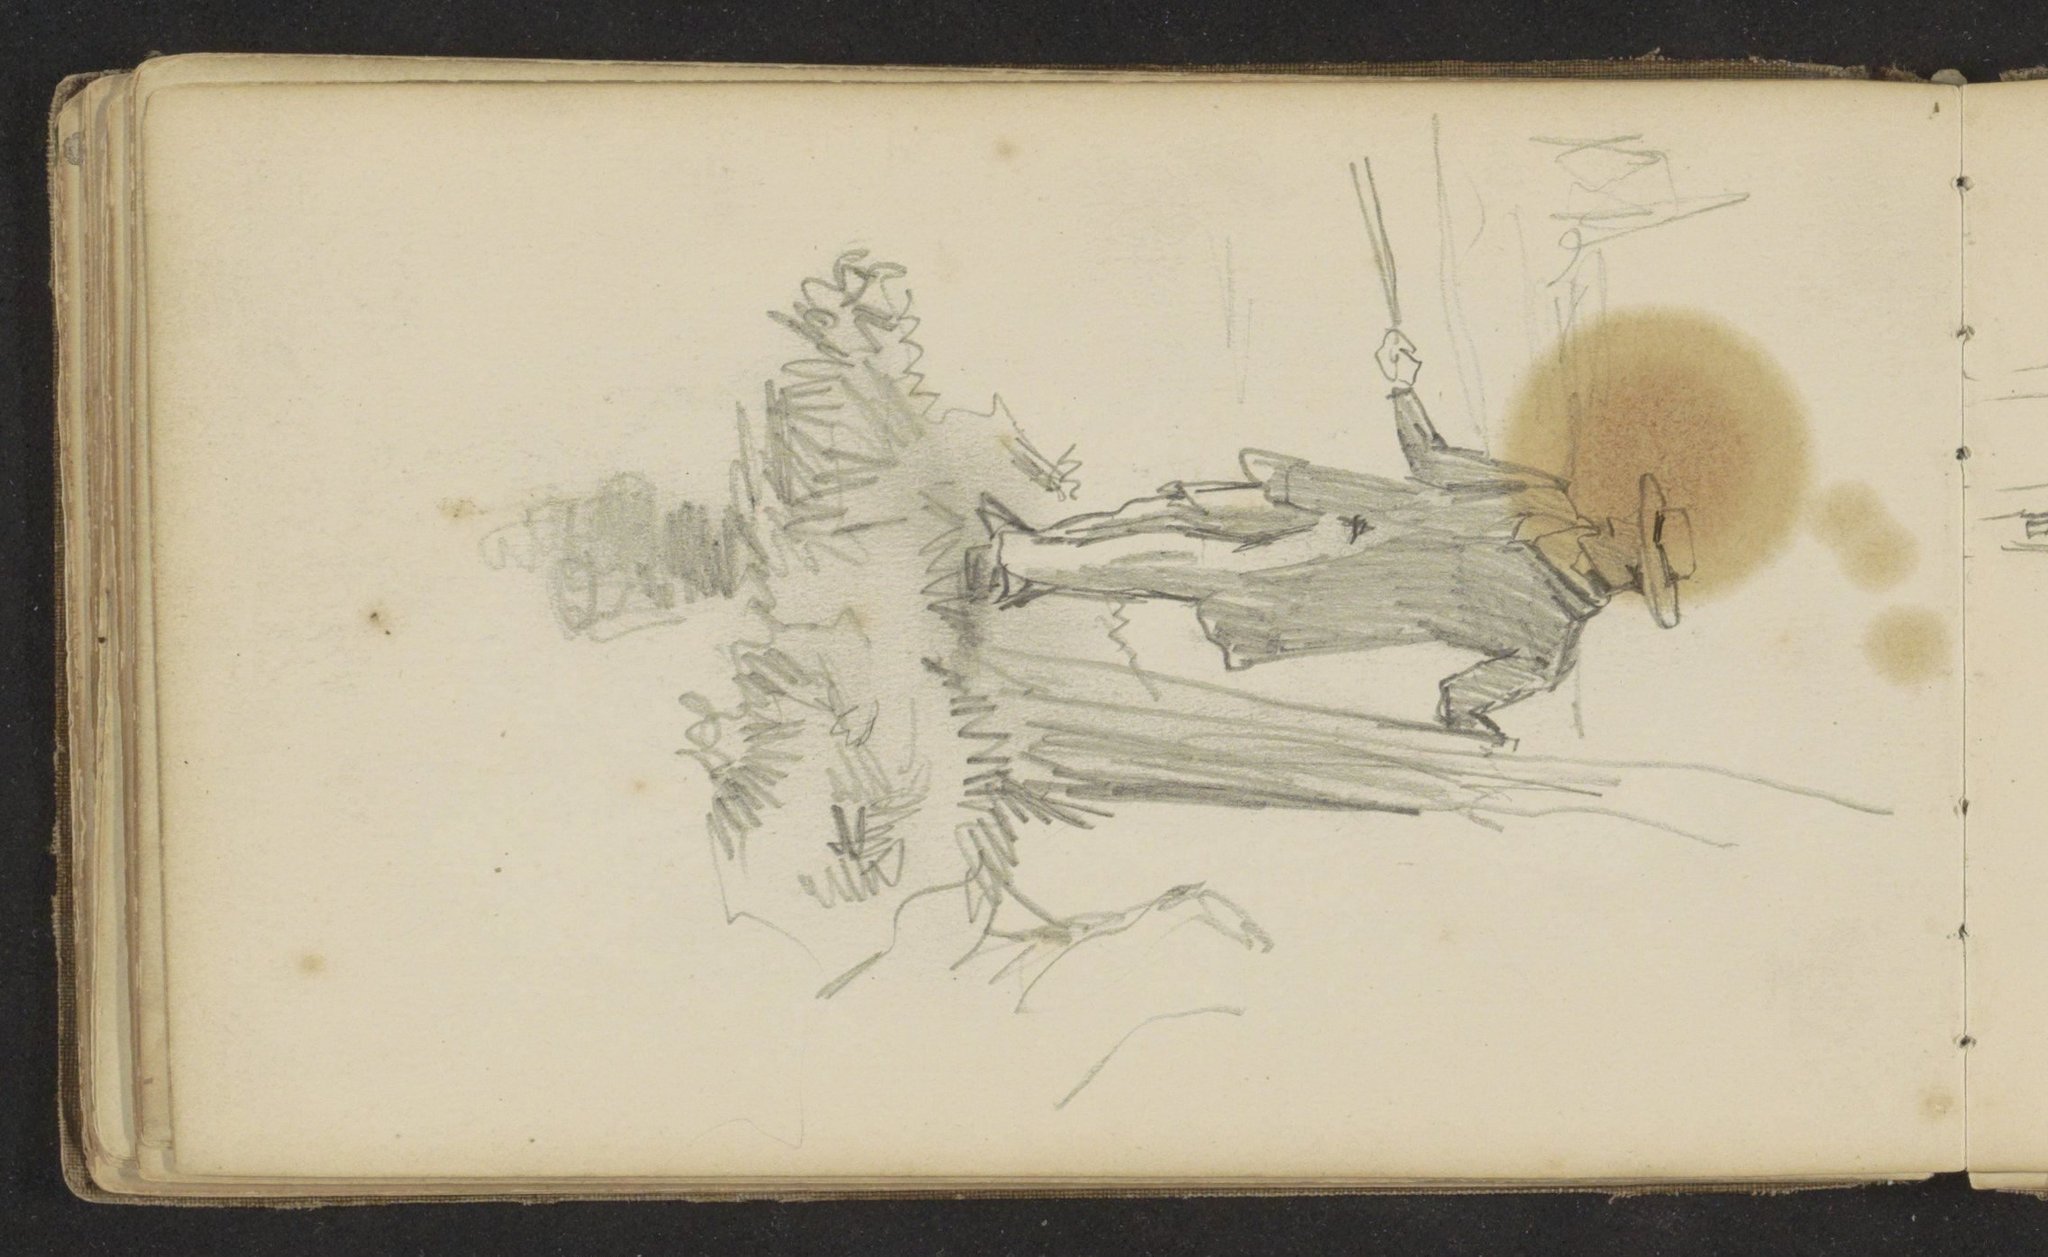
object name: sketchbook leaf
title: Man met wandelstok leunend tegen een boom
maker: johan hendrik weissenbruch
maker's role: draughtsman, painter, print maker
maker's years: 1824-1903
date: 1834-1903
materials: paper, pencil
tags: walking-stick, staff, trees (+ stem, trunk)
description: Blad 32 verso uit een schetsboek met 43 bladen.